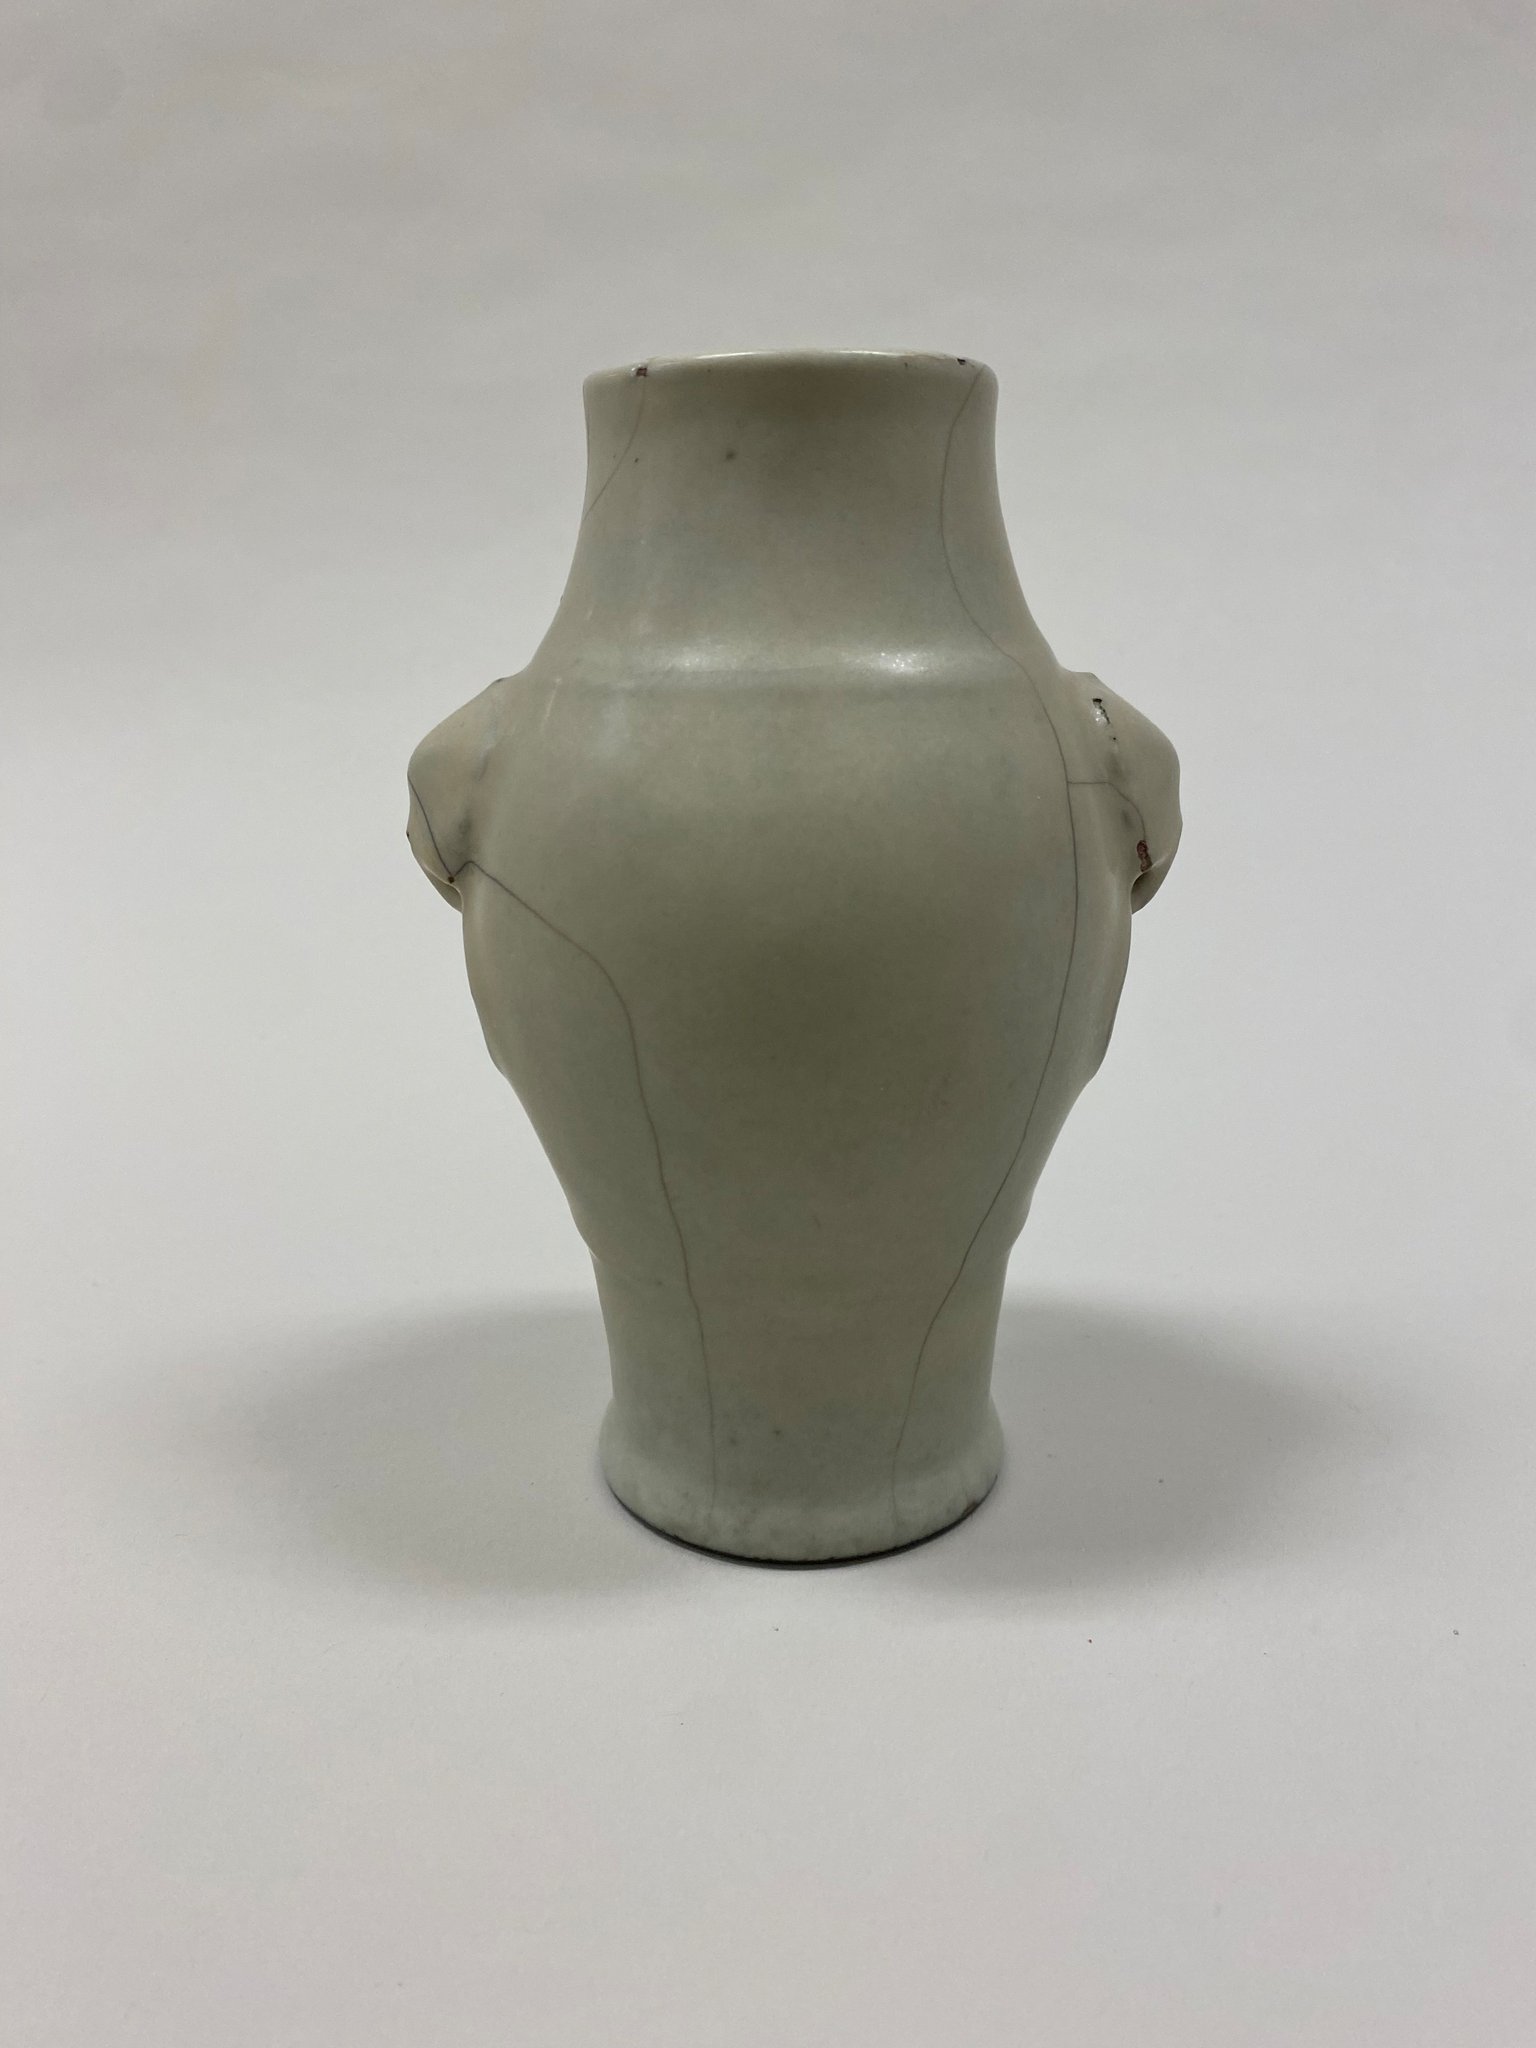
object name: vase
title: Vase with animal-masks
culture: chinese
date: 1701-1800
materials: glaze, porcelain